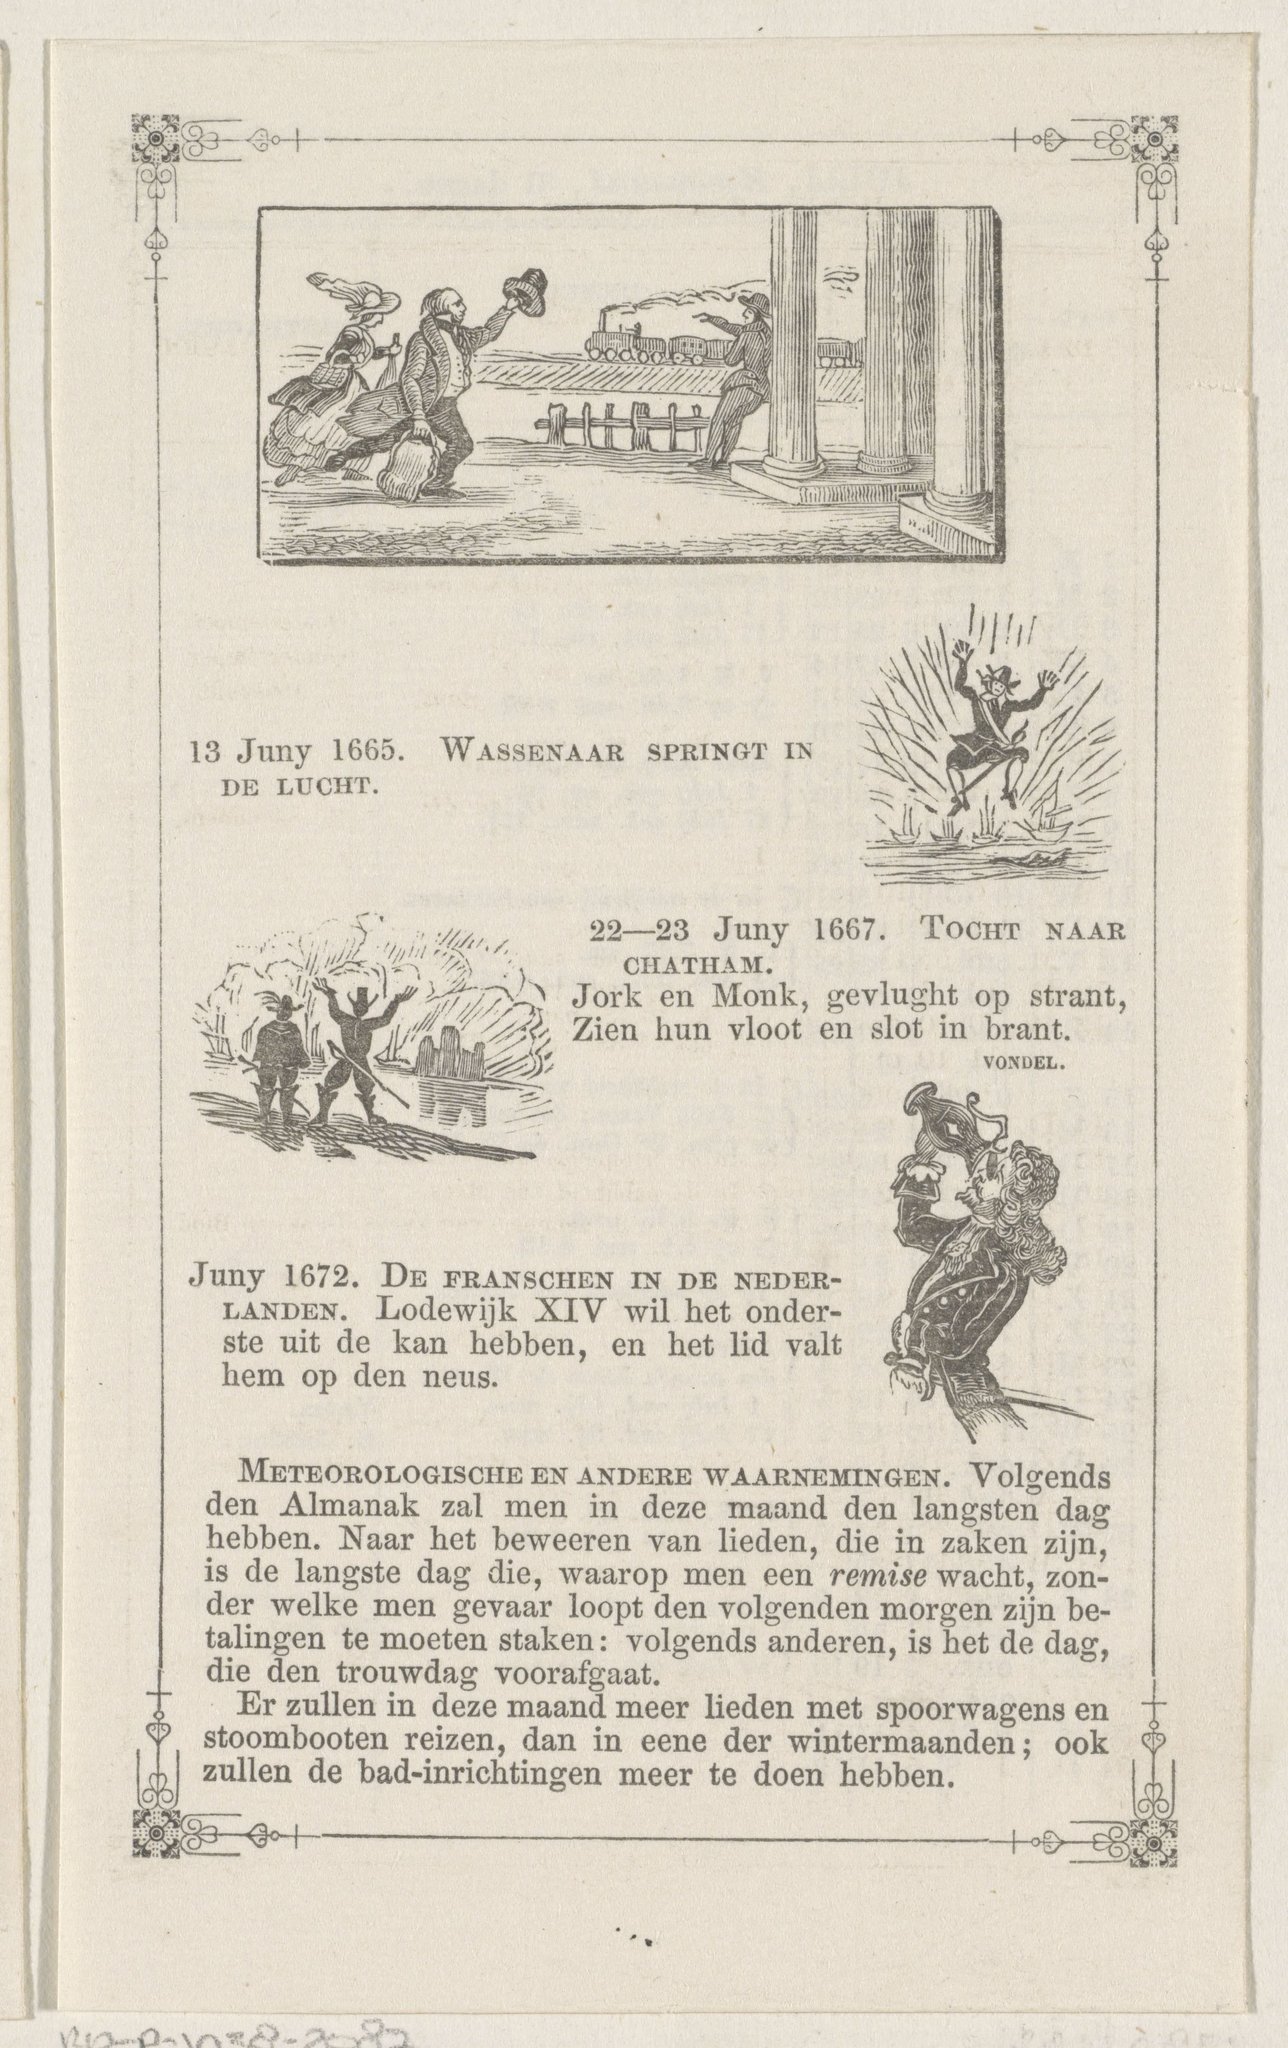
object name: print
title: Juni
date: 1849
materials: paper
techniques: letterpress printing, engraving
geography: amsterdam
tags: raid on the medway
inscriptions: collector's mark: Lugt 2760, collector's mark: Lugt 2228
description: Midden boven een voorstelling van figuren rennend naar een vertrekkende trein. Daaronder een aantal voorstellingen van gebeurtenissen die plaatsvonden in de maand juni, waaronder de Tocht naar Chatham in 1667. Midden onder meteorologische en andere waarnemeningen voor de maand juni in 1849.